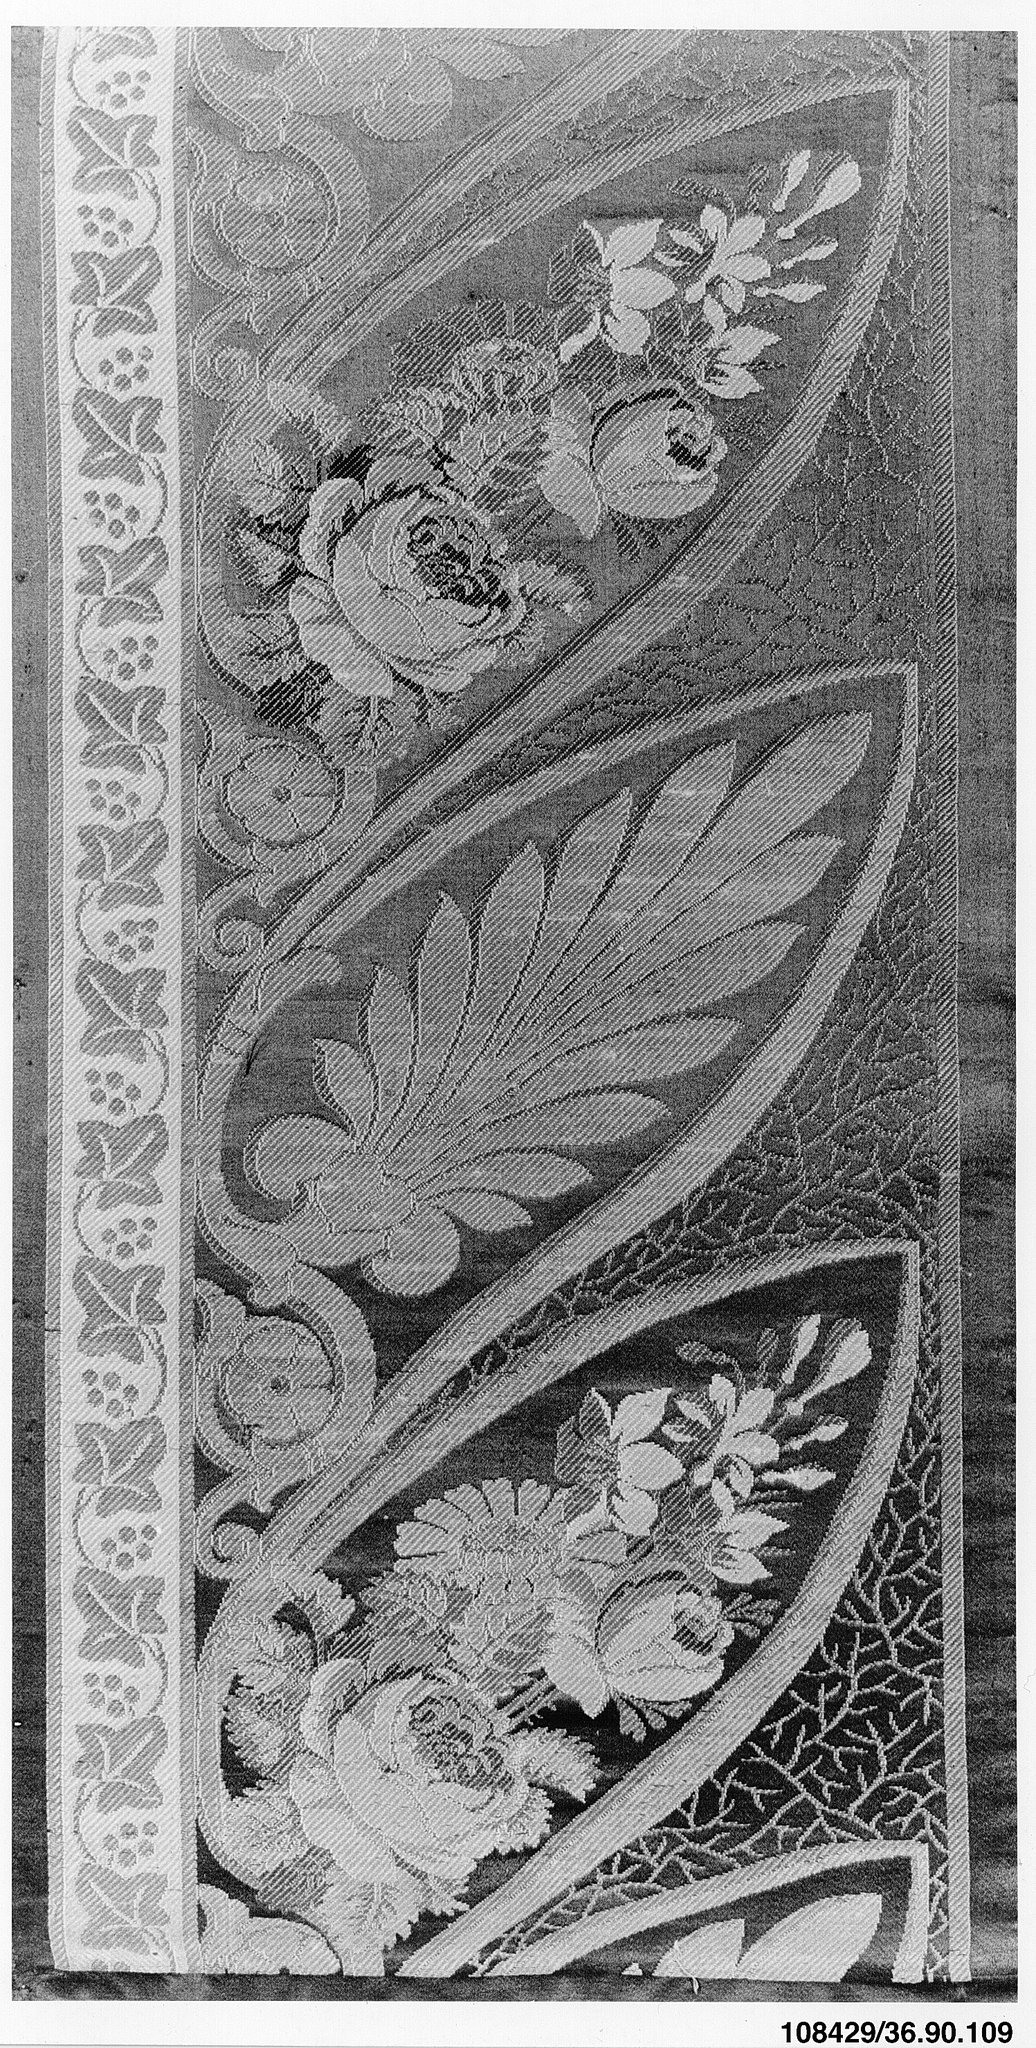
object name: border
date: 1805-1815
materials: silk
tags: roses